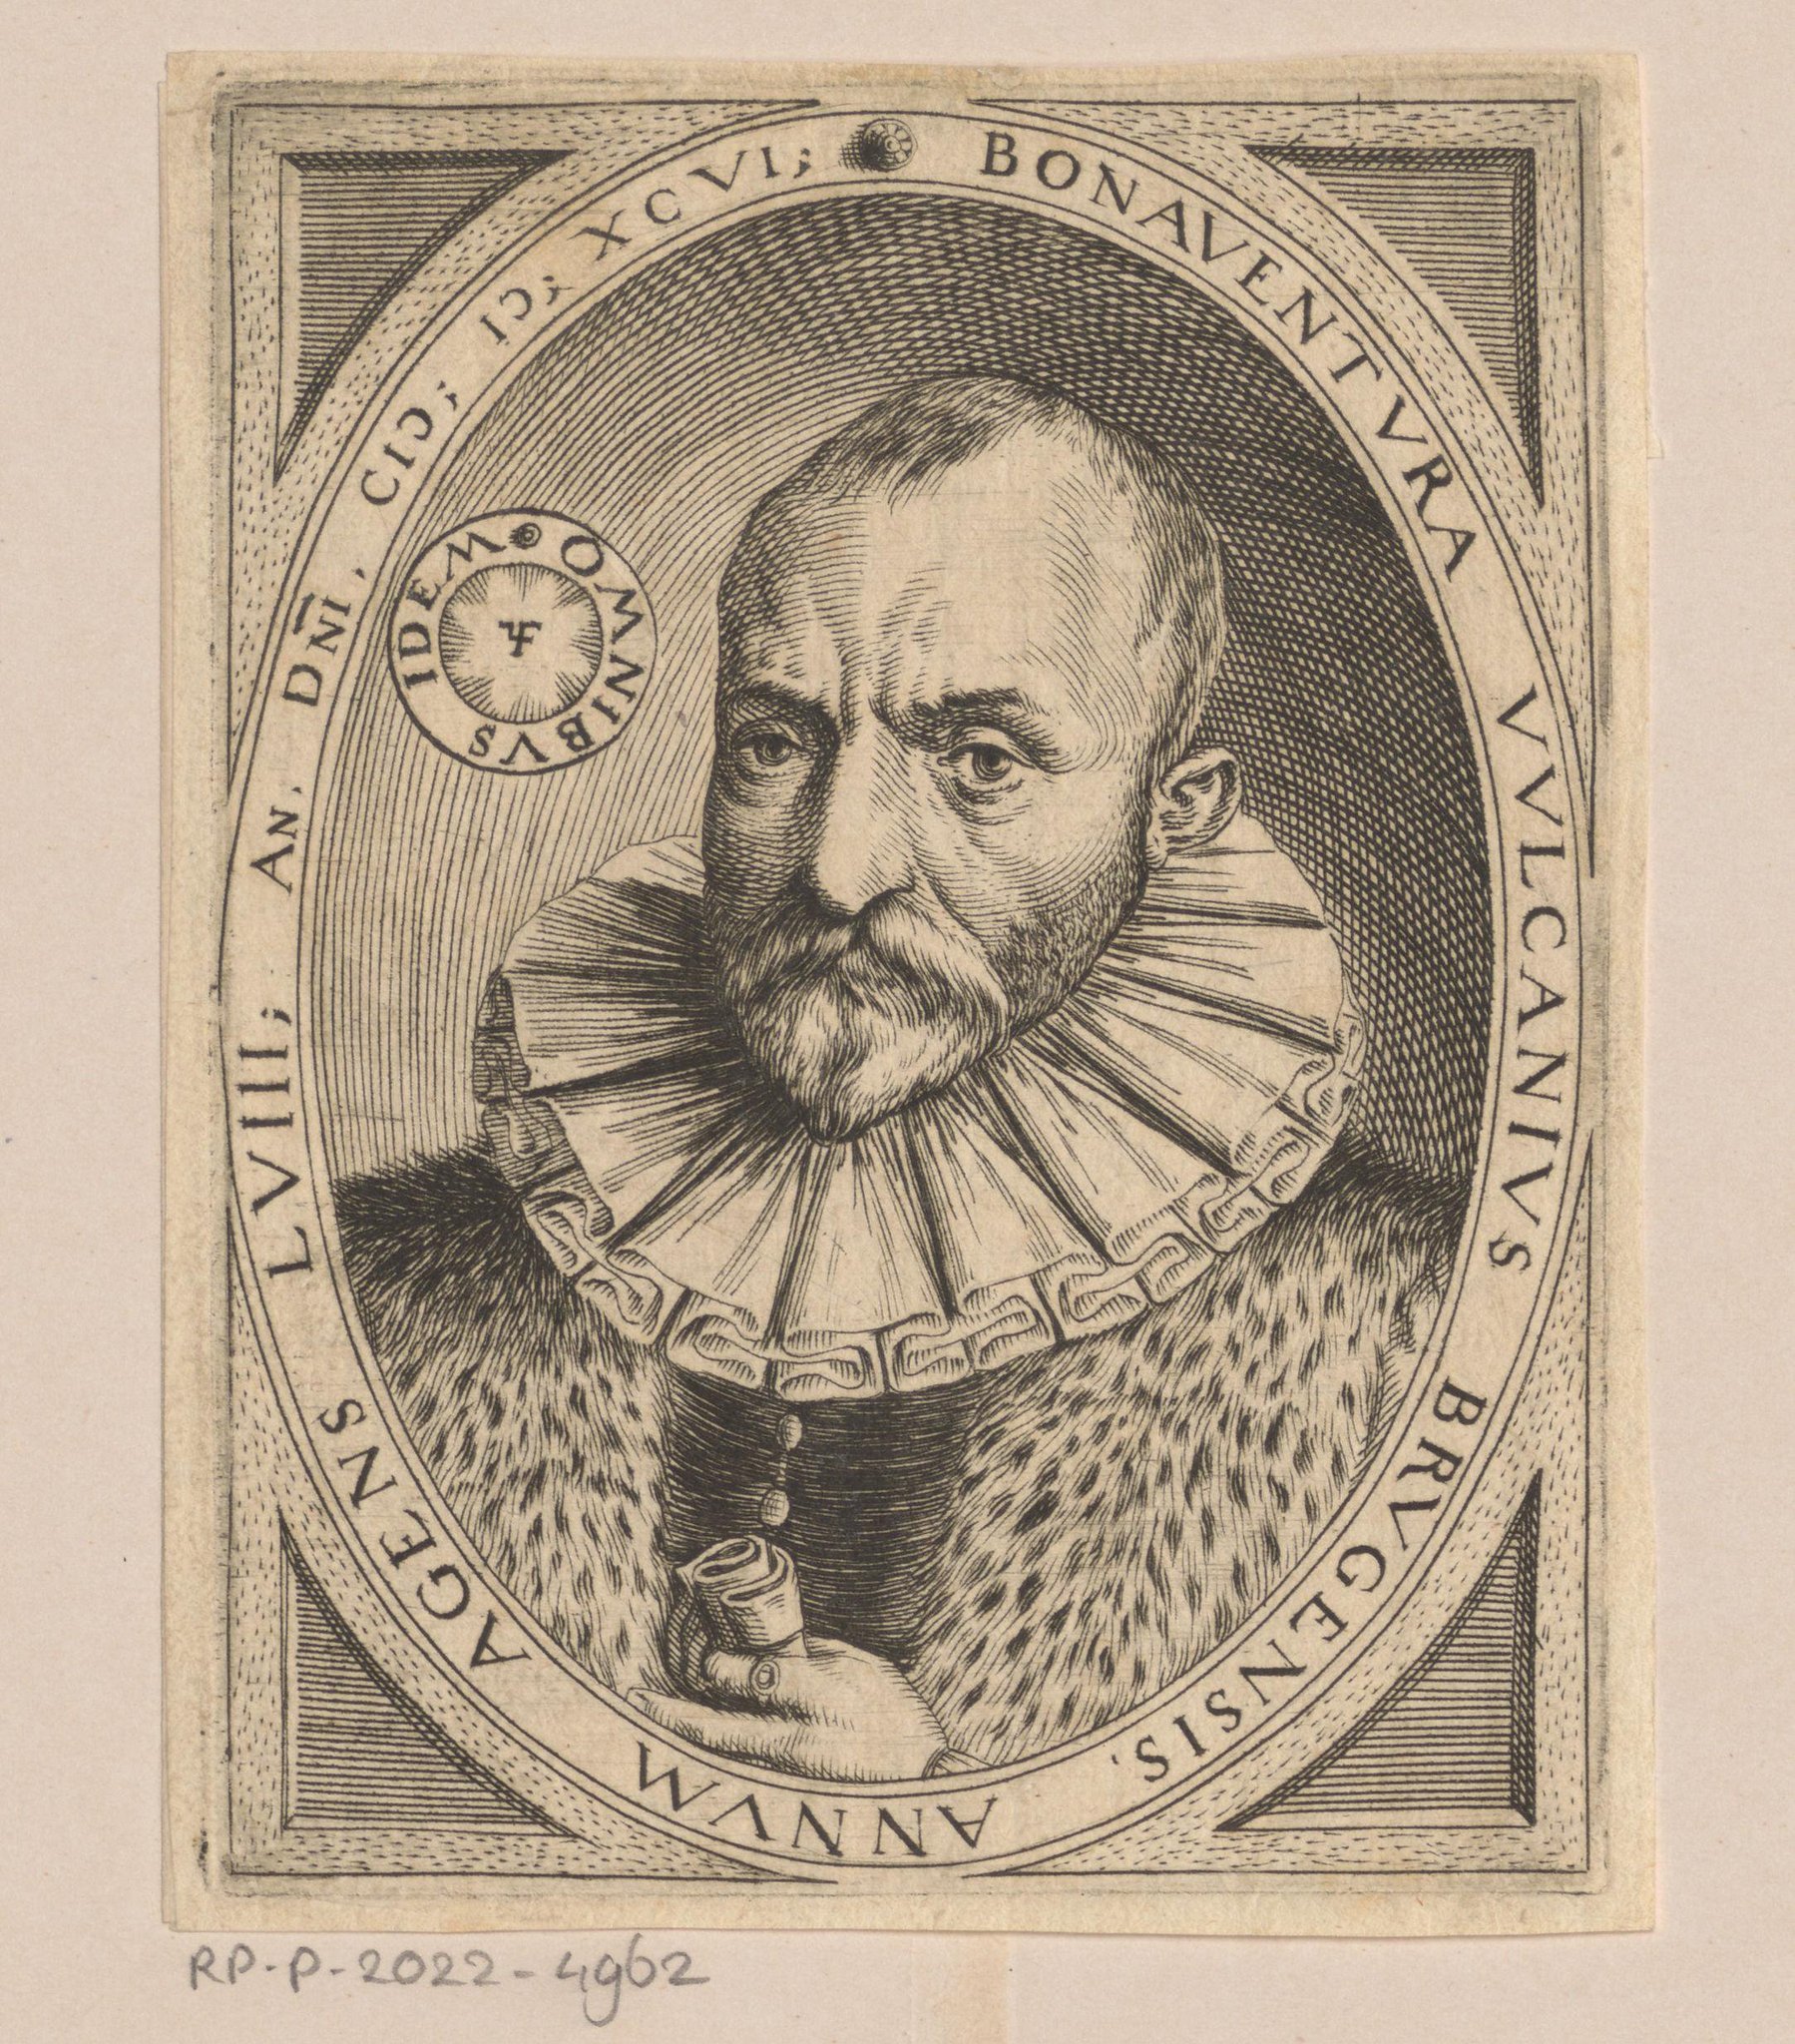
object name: print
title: Portret van Bonaventura Vulcanius op 58-jarige leeftijd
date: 1715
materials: paper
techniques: engraving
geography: leiden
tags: bruges, bonaventura vulcanius, scholar, philosopher, historical persons, portrait, self-portrait of graphic artist